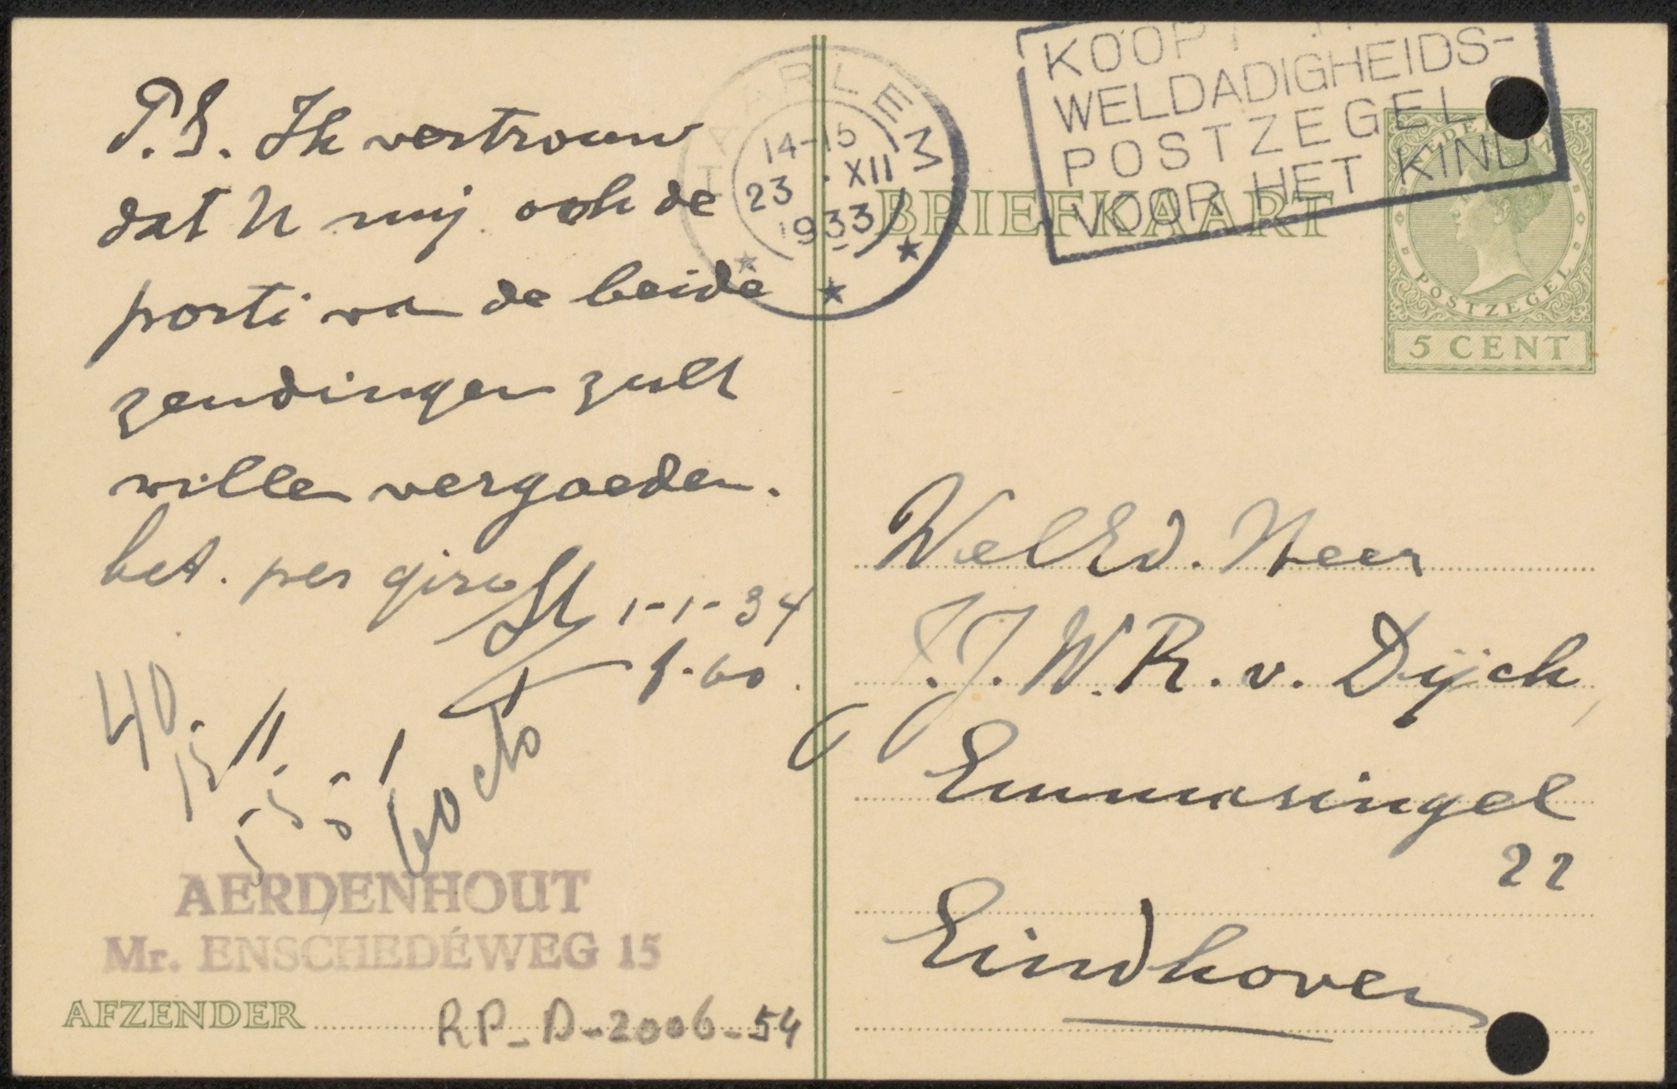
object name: postcard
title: Briefkaart aan de heer J.J.W.B. van Dijck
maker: johannes franciscus maria sterck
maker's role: letterkundige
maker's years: 1859-1941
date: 1933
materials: cardboard, ink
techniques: pen, writing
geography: aerdenhout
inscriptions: address: ‘AERDENHOUT/ Mr. ENSCHEDÉWEG 15’